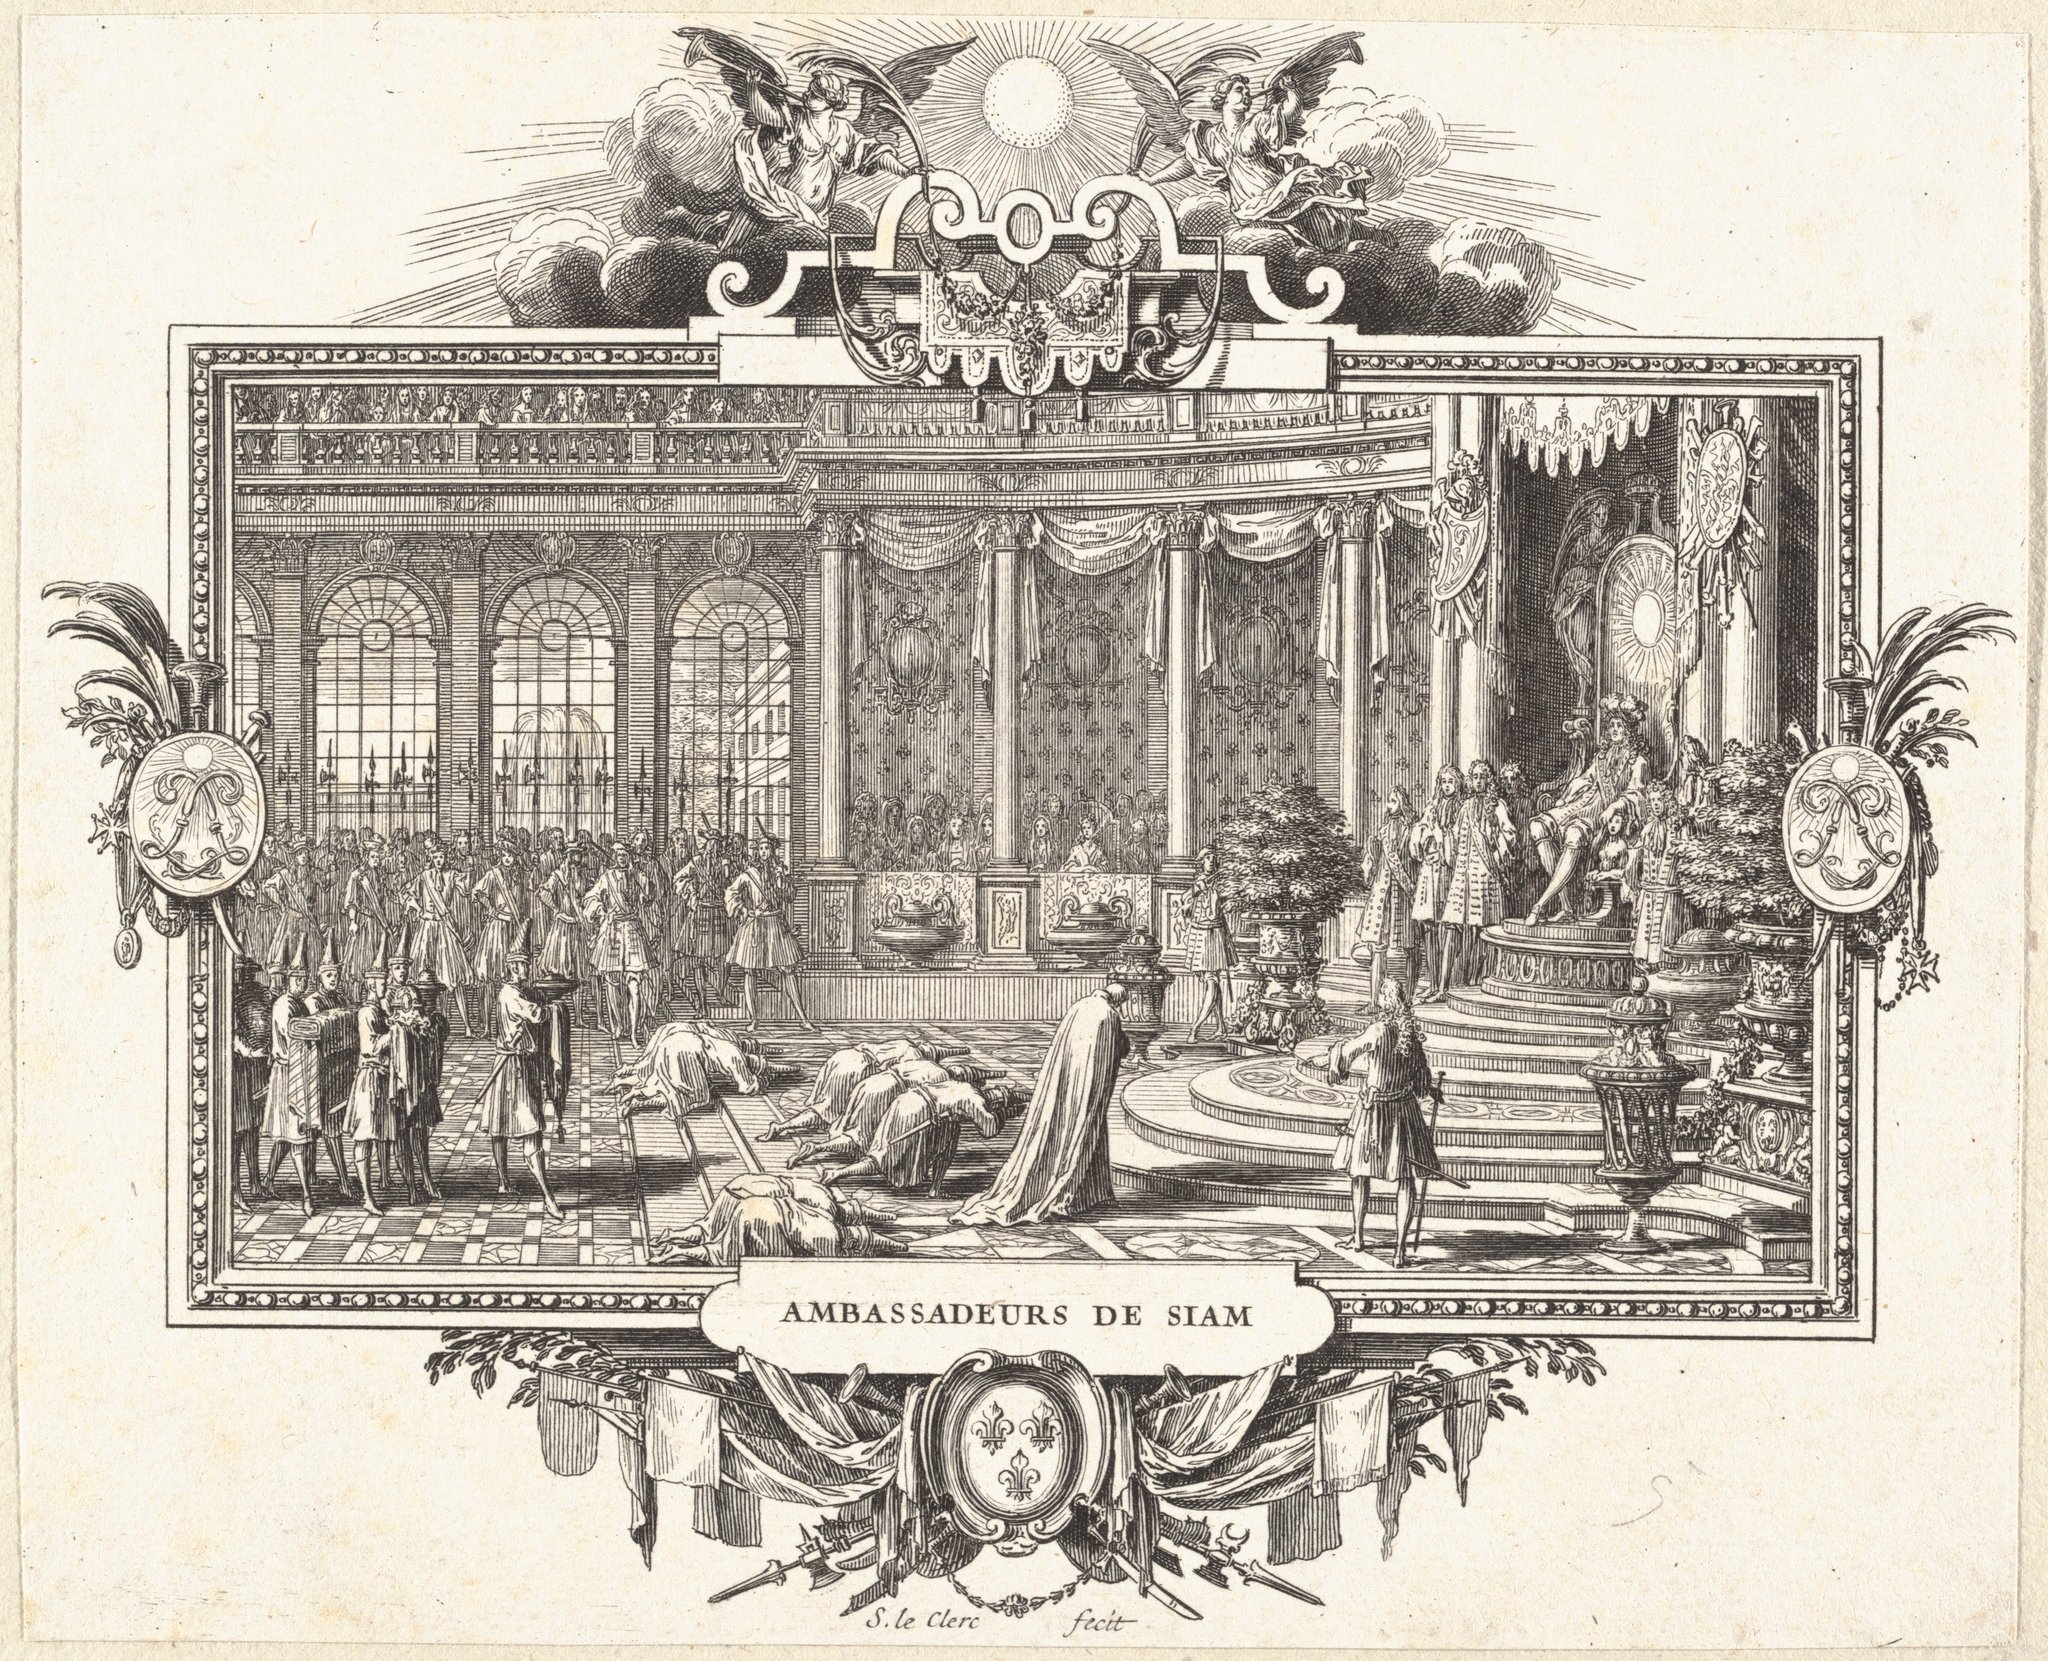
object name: print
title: Ambassador of Siam before Louis XIV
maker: sébastien leclerc (i)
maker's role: artist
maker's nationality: french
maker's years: 1637-1714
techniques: etching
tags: kings,louis xiv,men